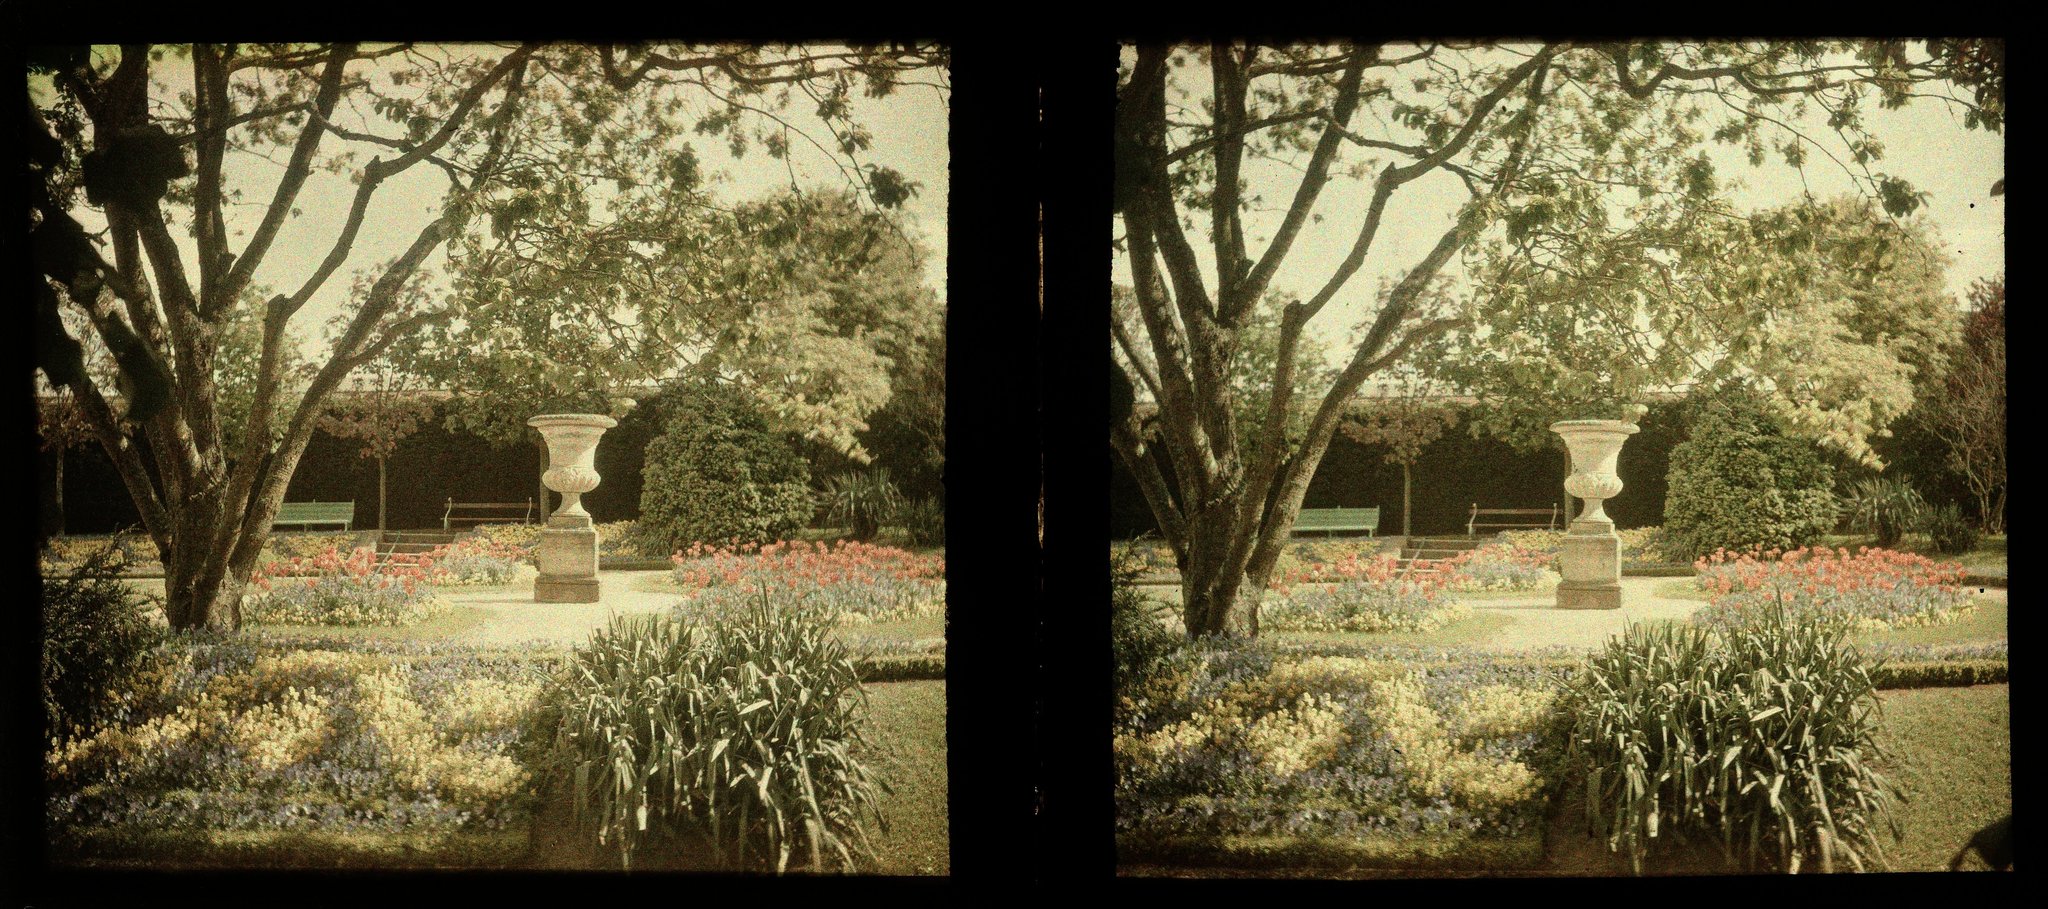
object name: stereograph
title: Tuin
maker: Anonymous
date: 1900-1985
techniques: autochrome process